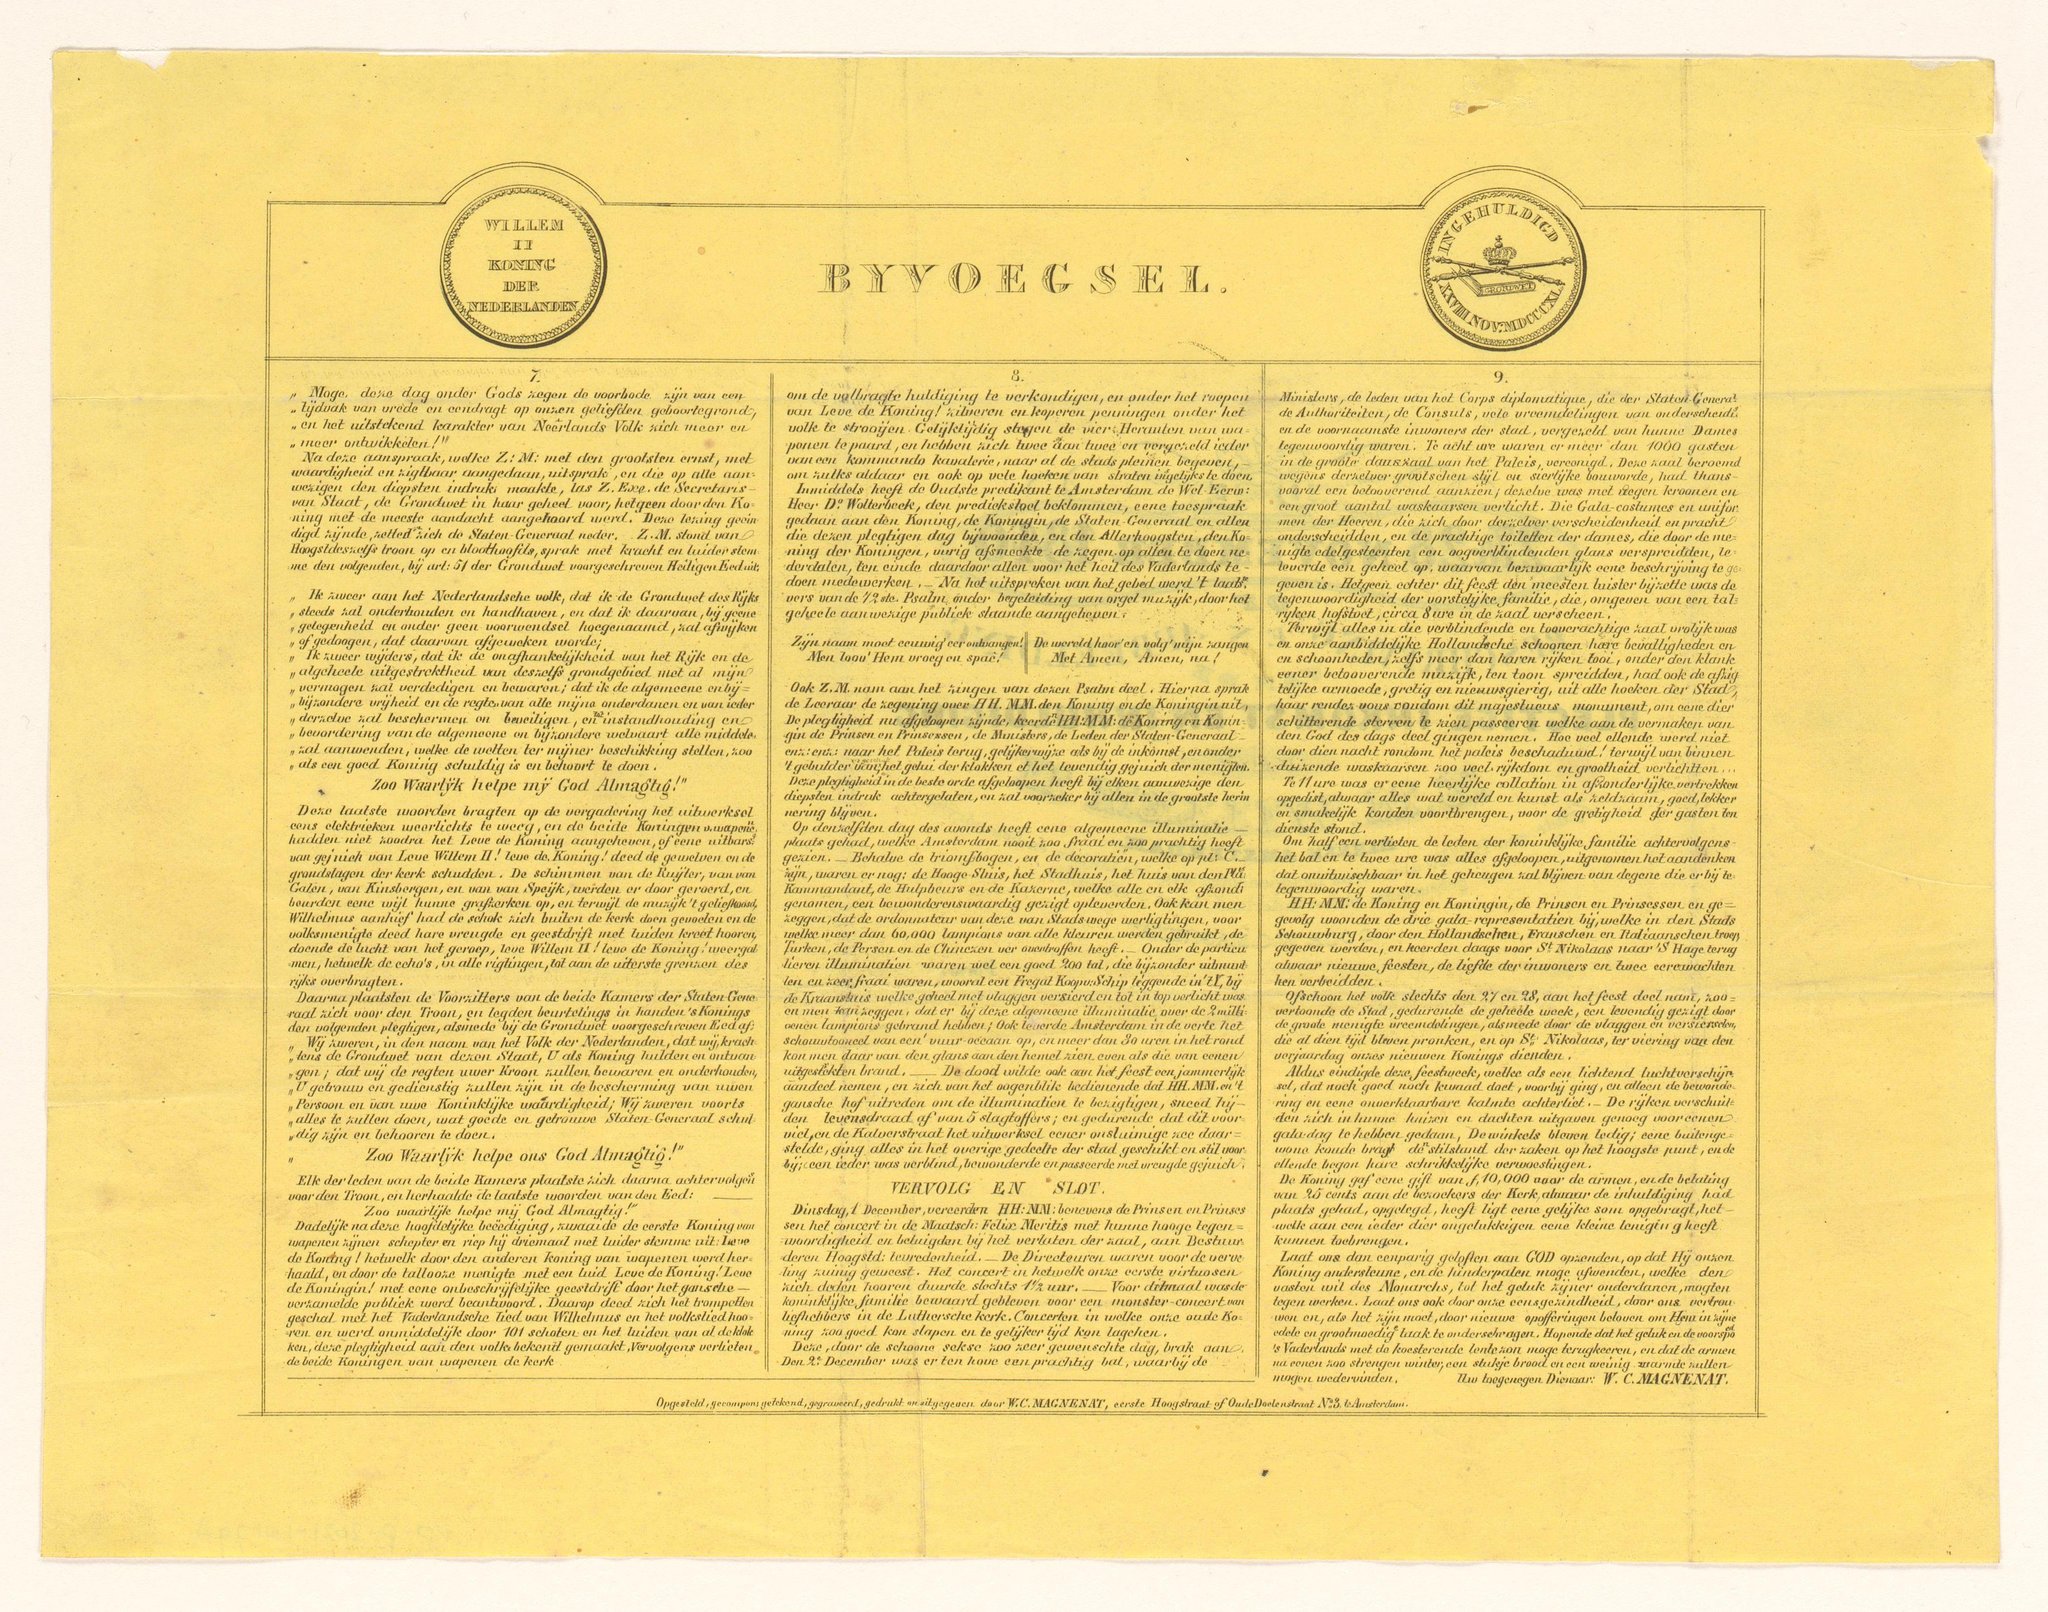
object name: print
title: Intrede en inhuldiging van koning Willem II te Amsterdam 27-28 november 1840 (omslag)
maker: willem charles magnenat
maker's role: print maker, printer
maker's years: 1803-1871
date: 1840-1841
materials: paper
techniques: engraving, etching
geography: amsterdam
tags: the hague, william ii of the netherlands, public festivities at other royal events, not meant or mentioned above, other forms of installation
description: Blad bedrukt op beide zijden en bedoeld als een omslag of envelop. Op de buitenzijde alleen de titel. Binnen het 'Byvoegsel' met het vervolg van de tekst van de brief met een beschrijving in drie kolommen van de gebeurtenissen op 27 en 28 november 1840. Bij dit blad hoort een andere prent (de brief) met voorstellingen en teksten van deze gebeurtenissen dat opgevouwen in dit blad past.